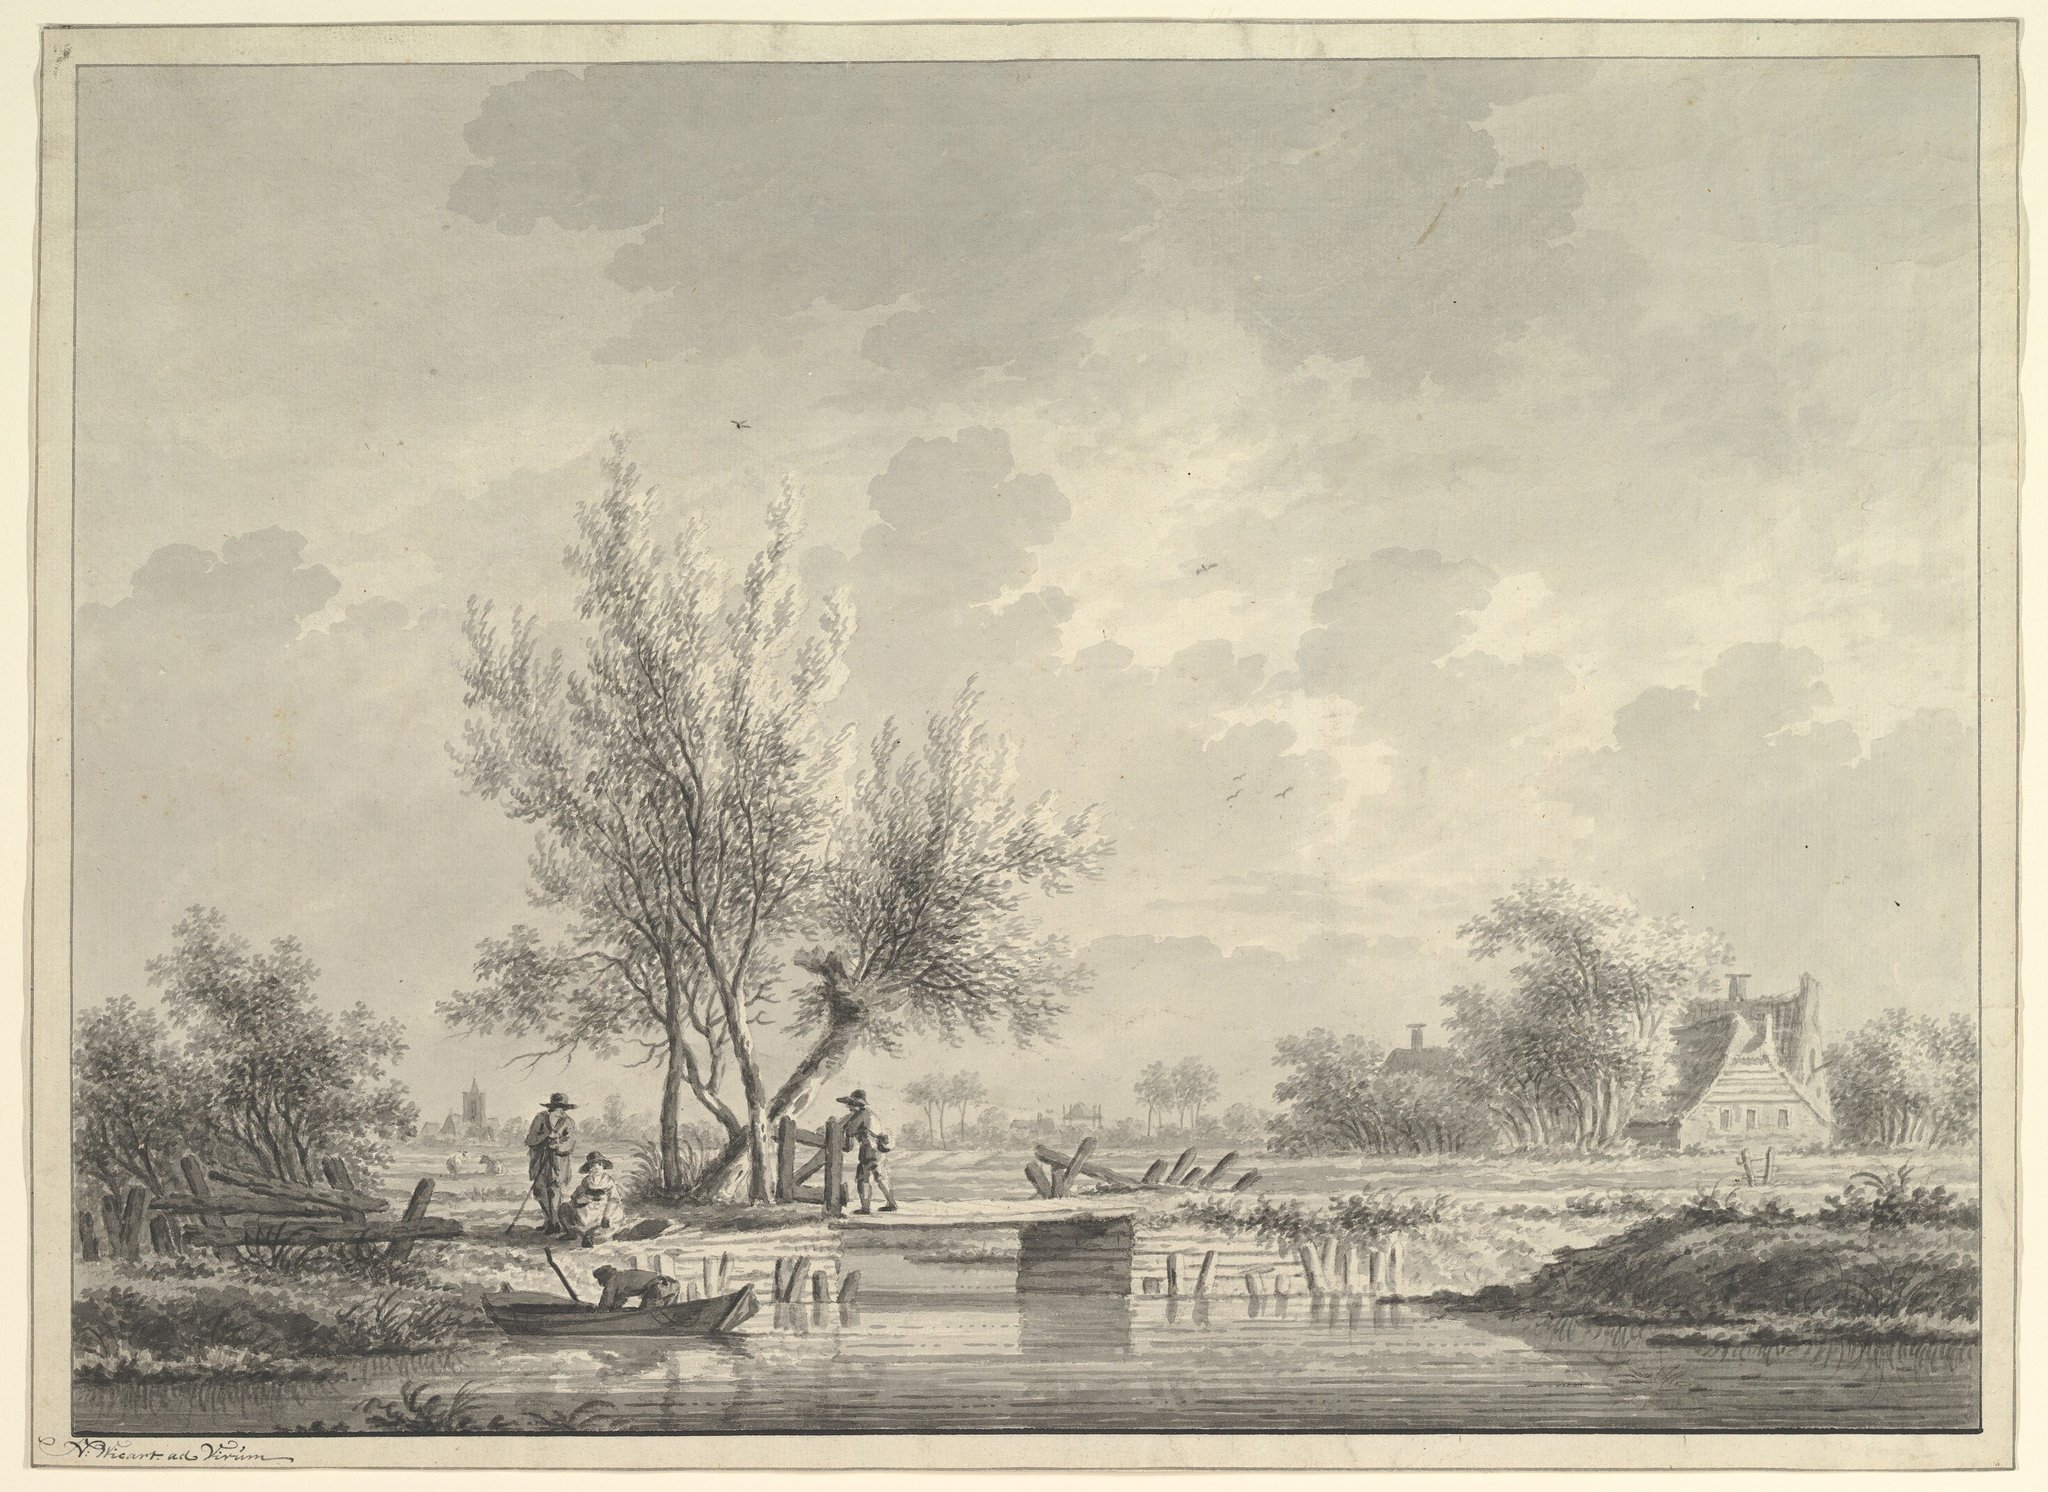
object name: drawing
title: View of a Bridge in the Dutch Countryside with Figures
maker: nicolaas wicart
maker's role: artist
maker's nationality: dutch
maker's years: 1748-1815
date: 1734-1833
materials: chalk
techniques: brush, wash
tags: men,landscapes,boats